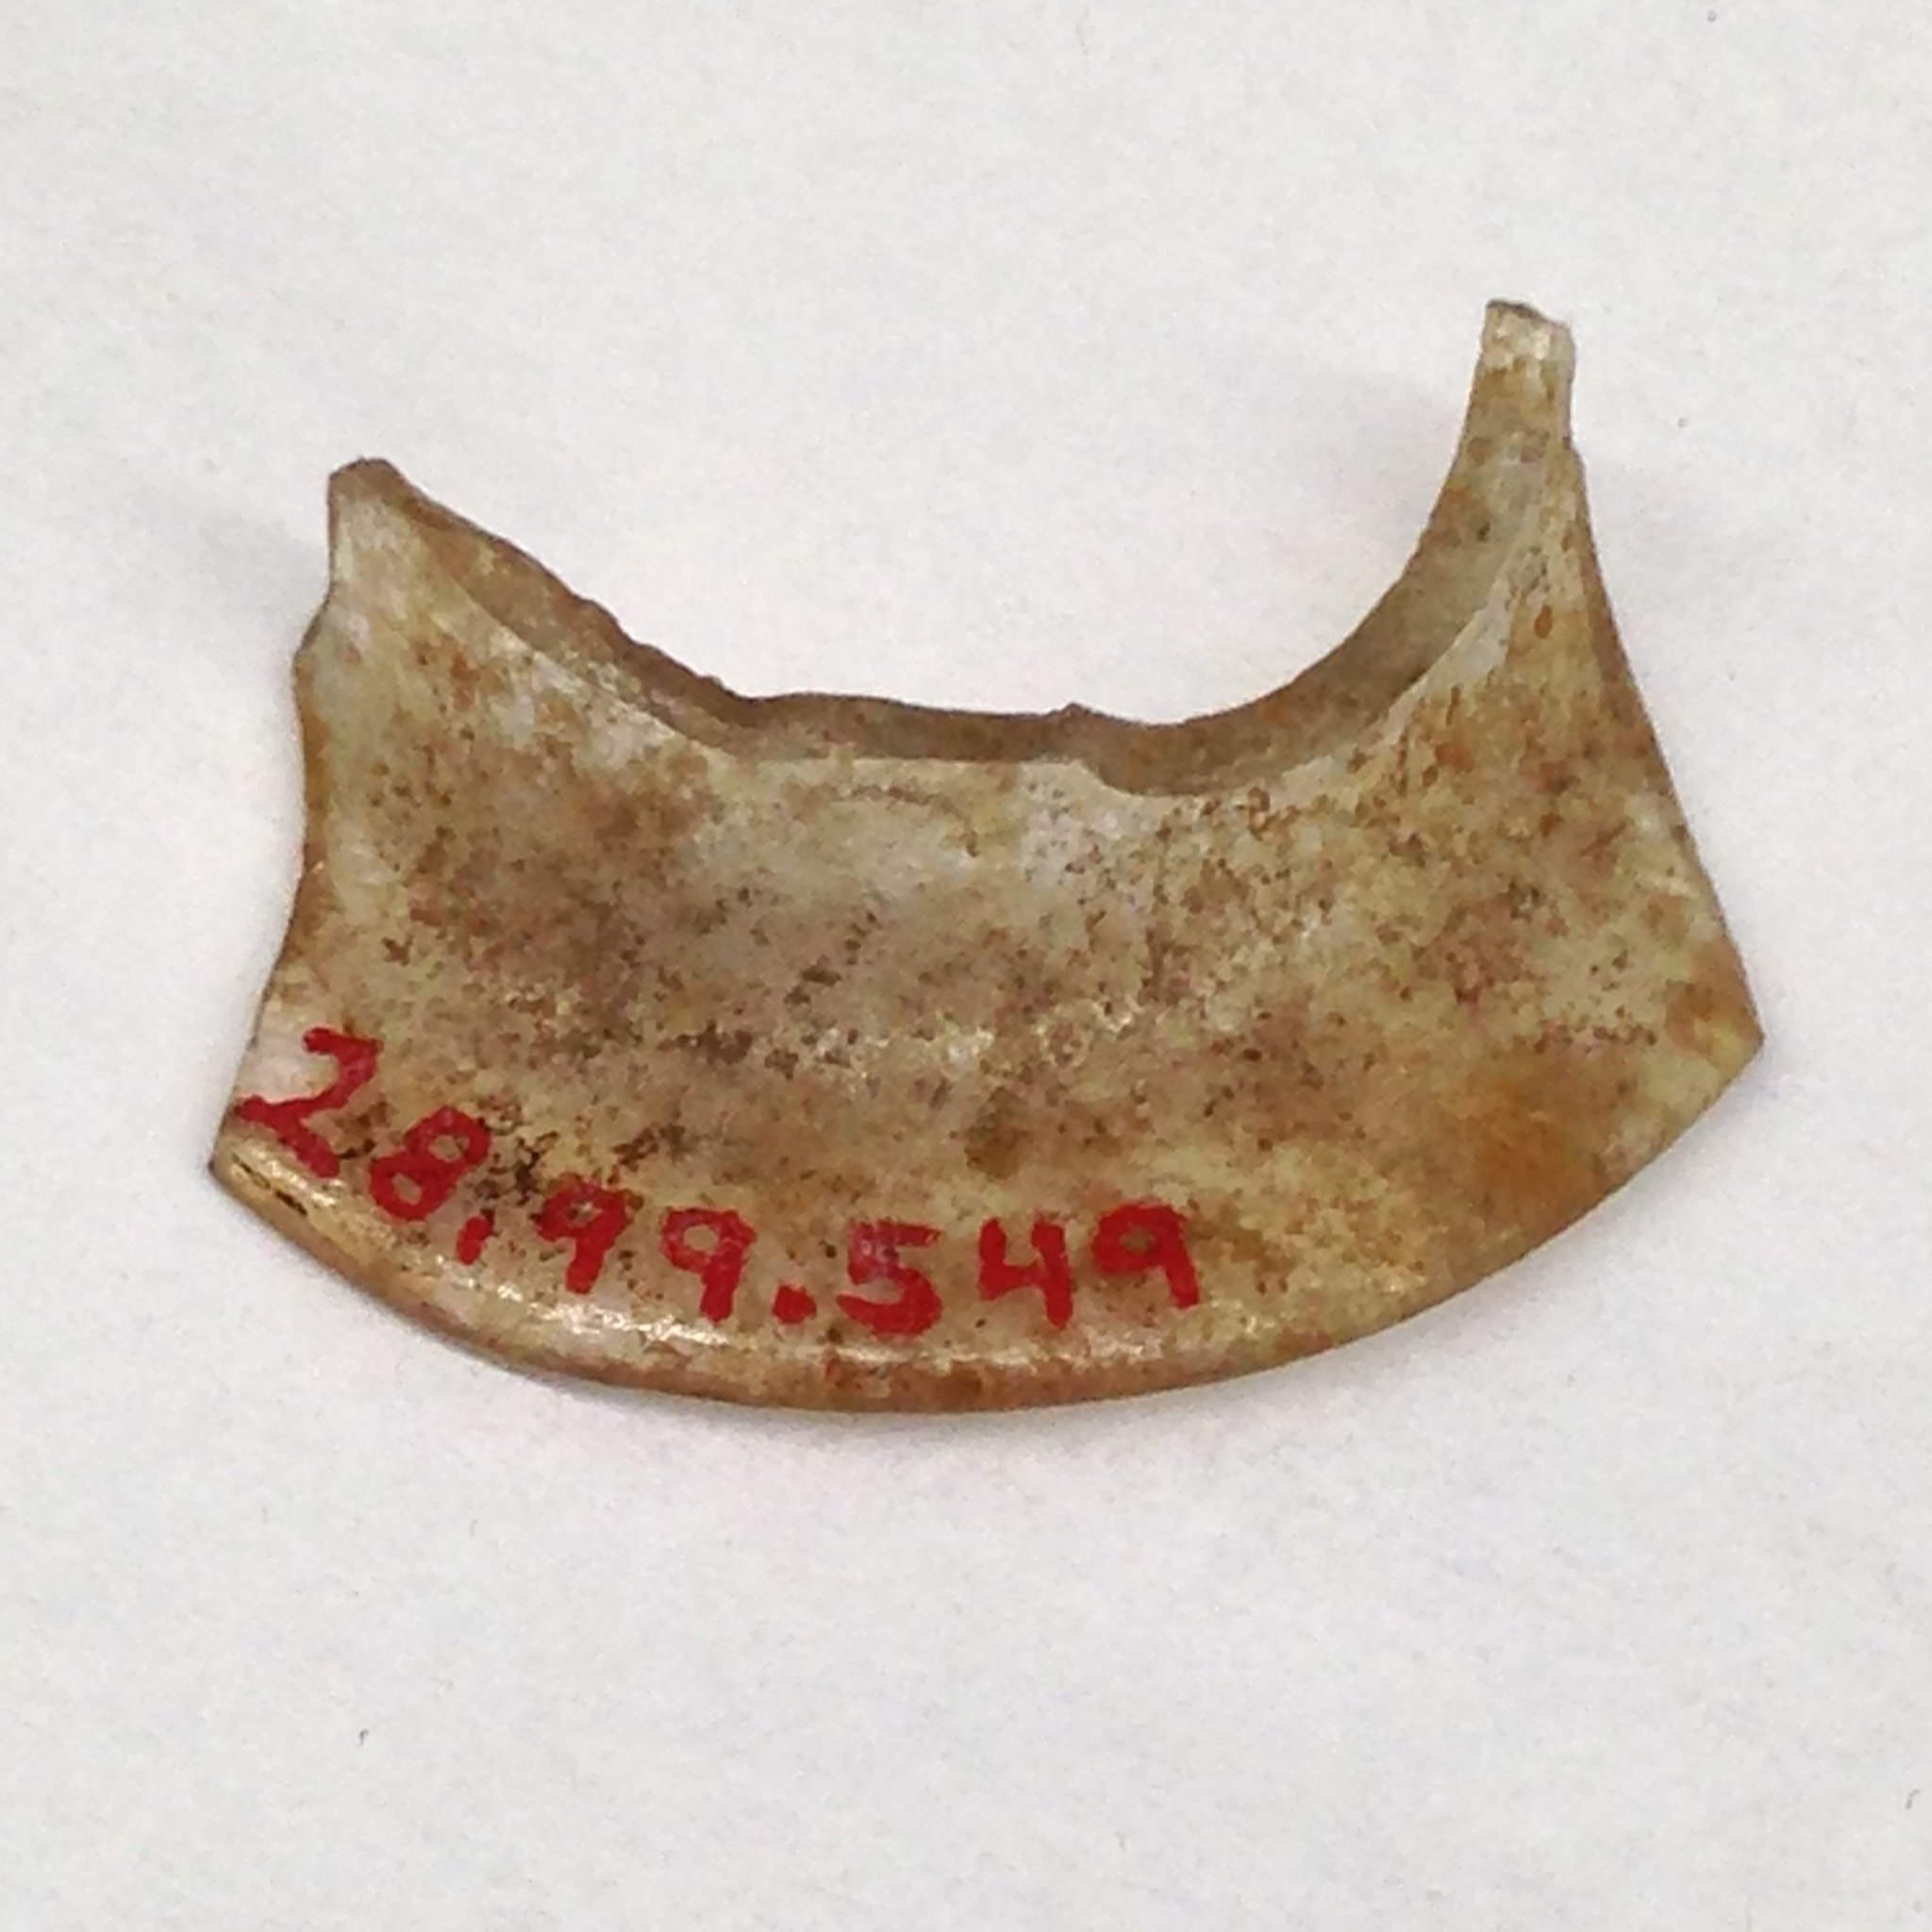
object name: fragment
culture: european or middle eastern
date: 1150-1250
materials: ceramic, glass